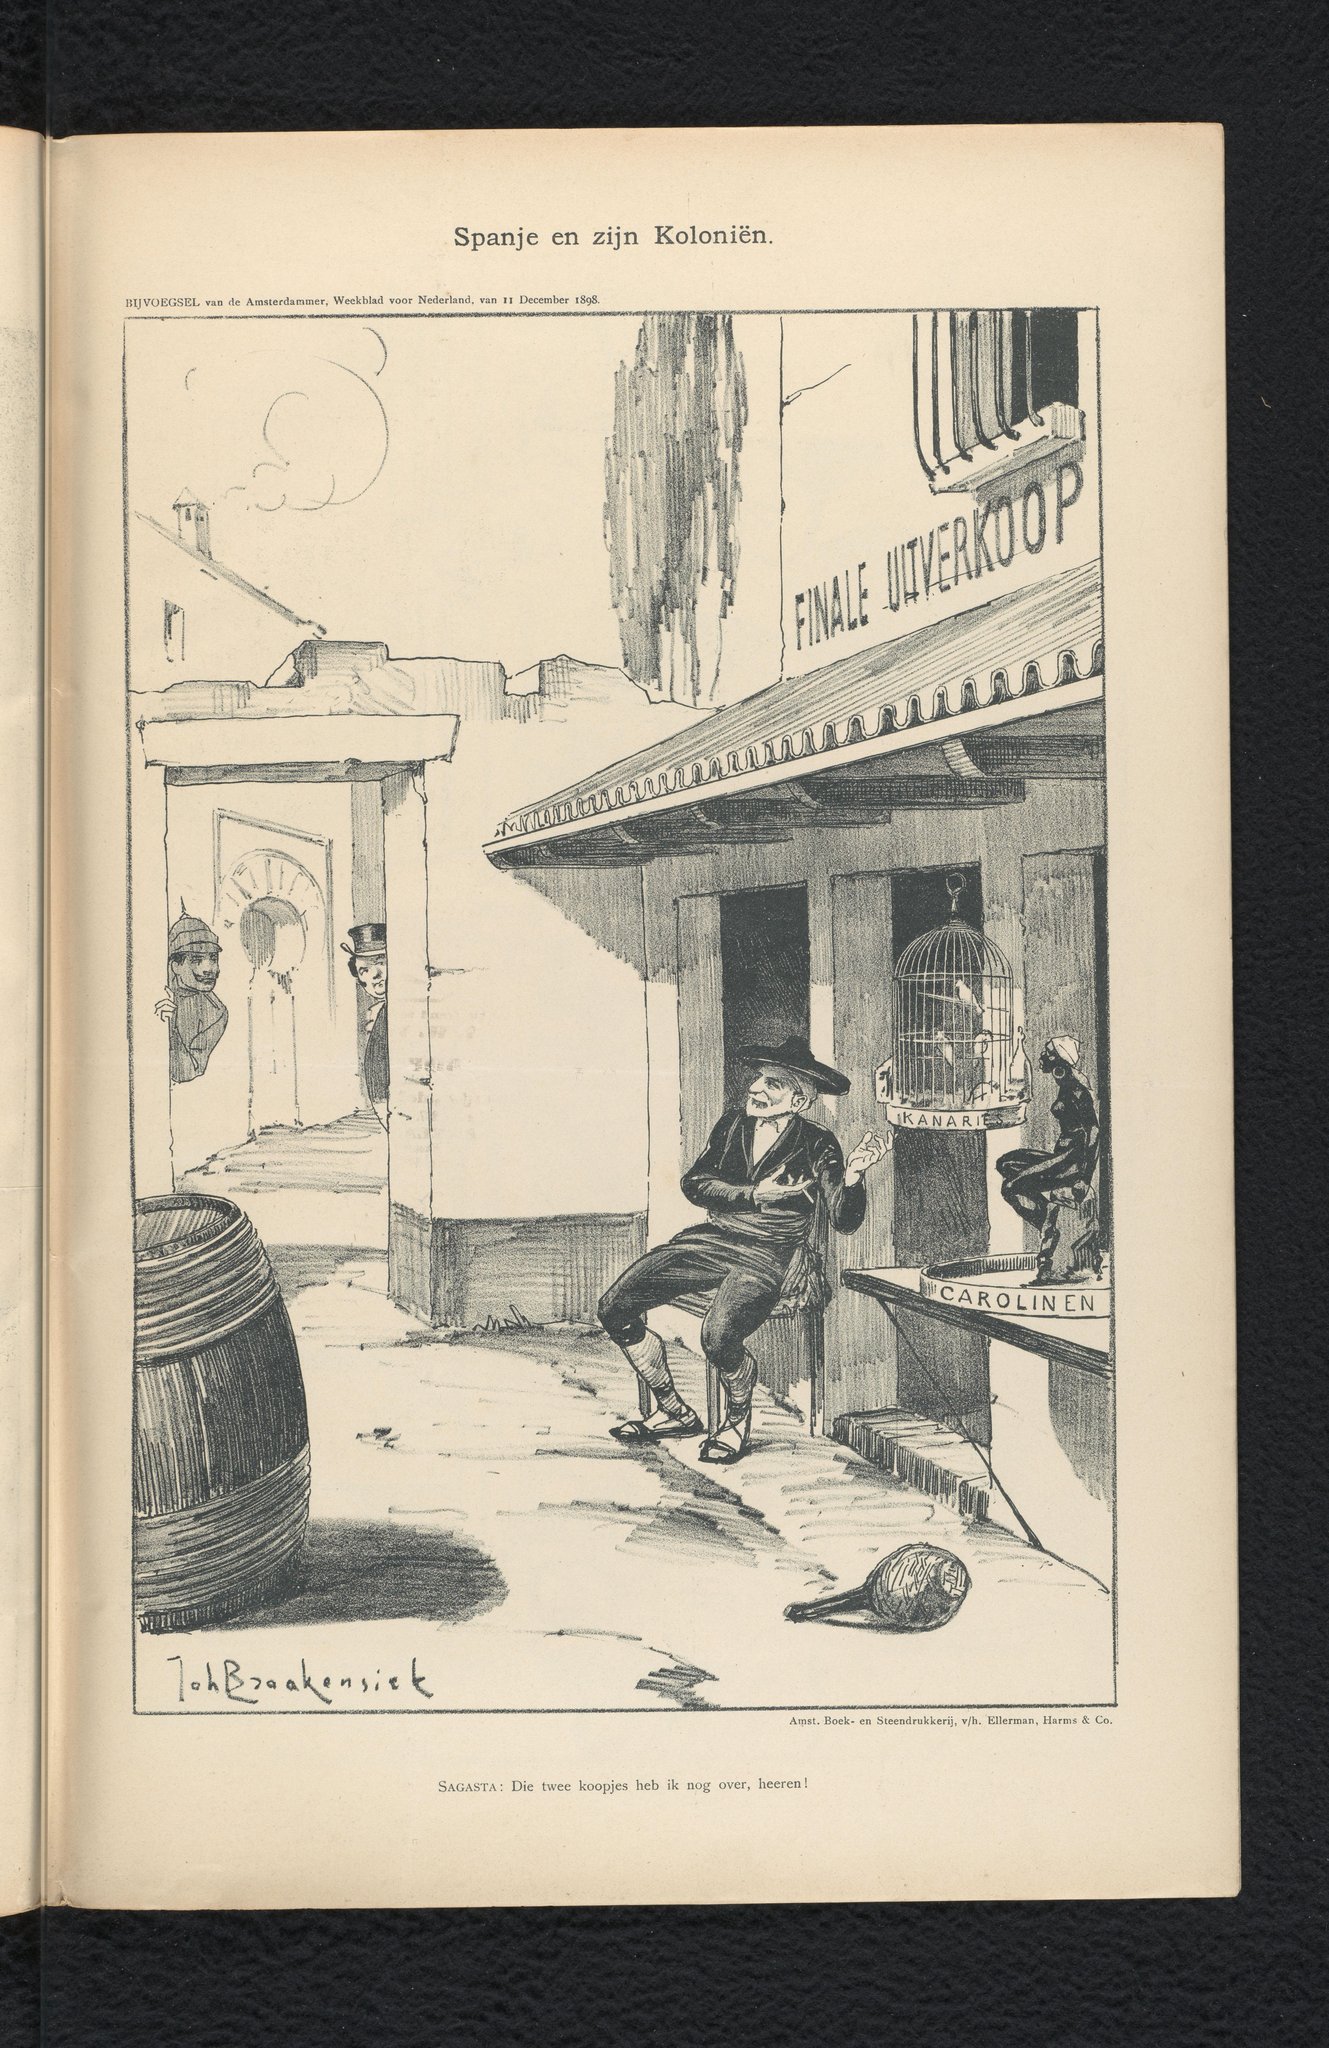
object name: cartoon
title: Spanje en zijn Koloniën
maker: johan braakensiek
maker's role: draughtsman, print maker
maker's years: 1858-1940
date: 1898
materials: paper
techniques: lithograph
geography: amsterdam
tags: wilhelm ii (keizer van duitsland), colonial system, personifications of countries, nations, states, districts, etc., shopkeeper, political caricatures and satires, caroline islands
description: De Spaanse premier Sagasta zittend voor zijn winkel biedt de Spaanse koloniën de Canarische Eilanden en de Carolinen (Caroline-eilanden) te koop aan. Duitsland en Engeland kijken voorzichtig om de hoek.